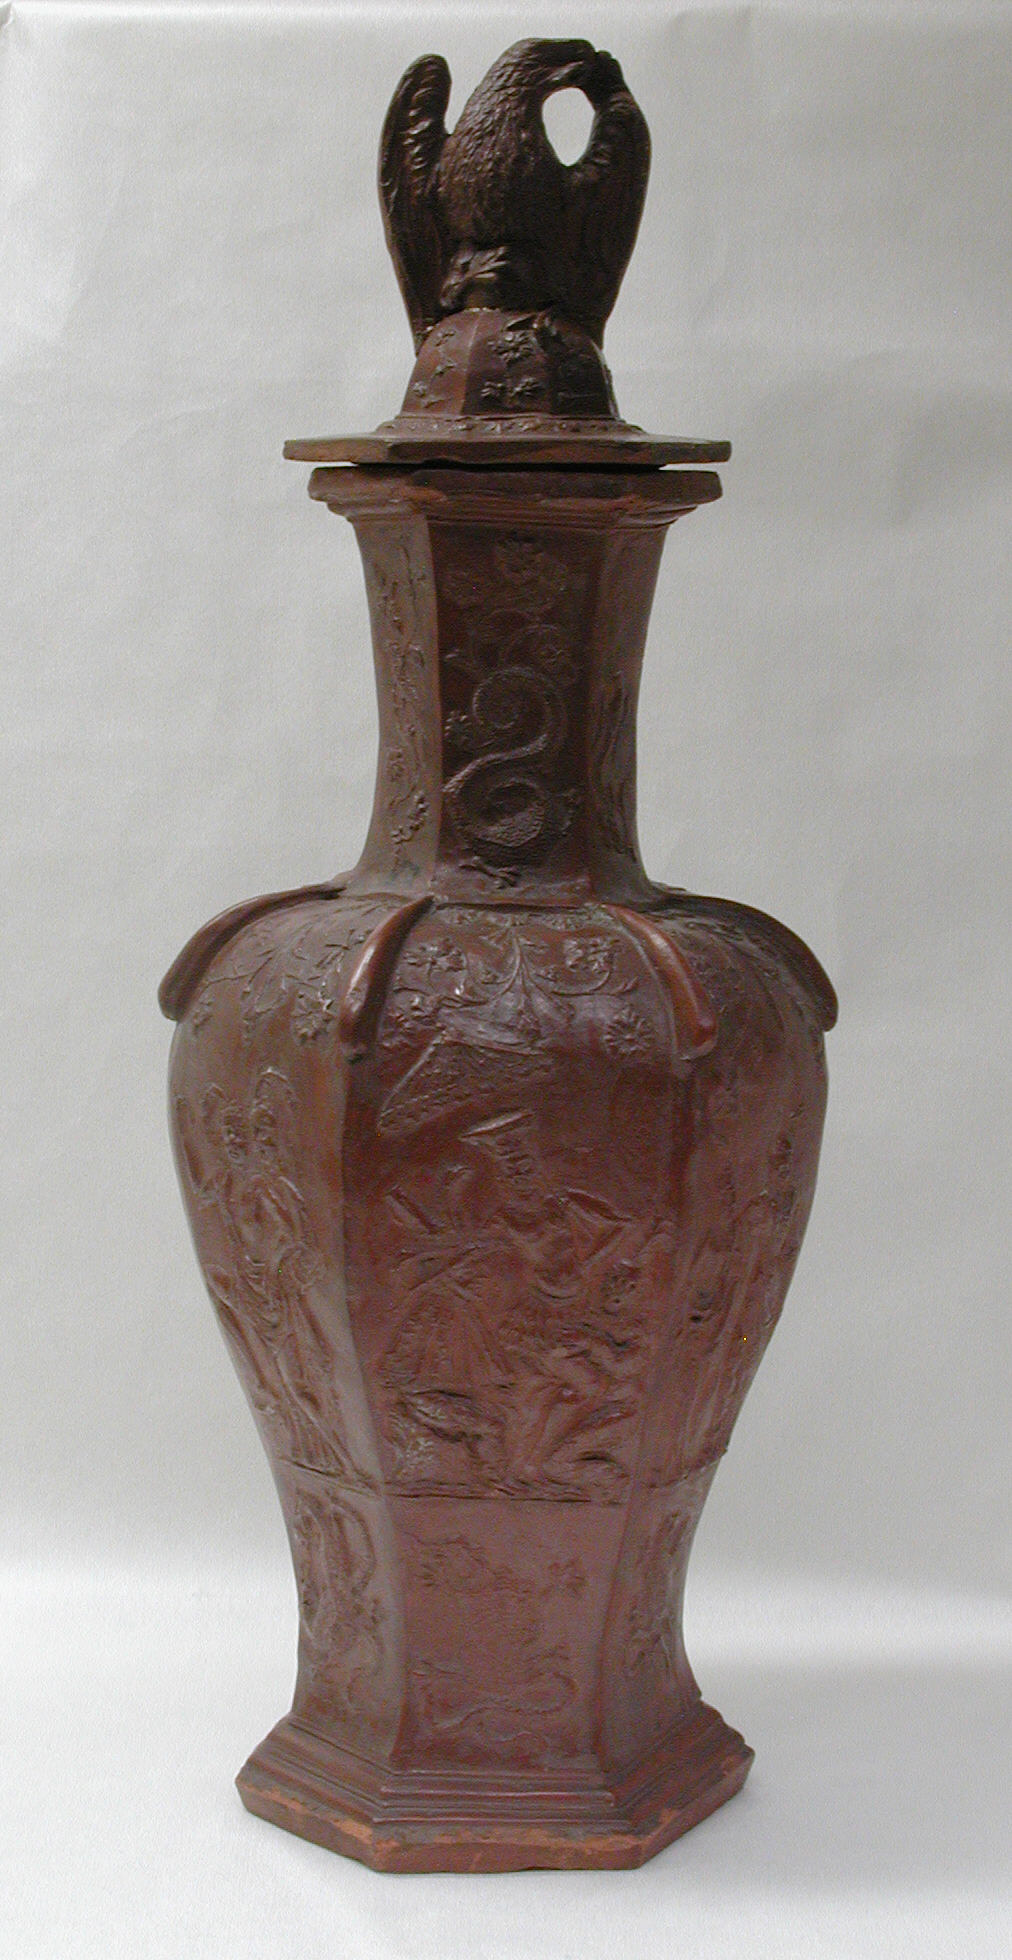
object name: vase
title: Hexagonal vase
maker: cornelius funcke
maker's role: factory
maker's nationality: german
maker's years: 1673-1733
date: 1650-1700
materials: earthenware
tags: human figures,dragons